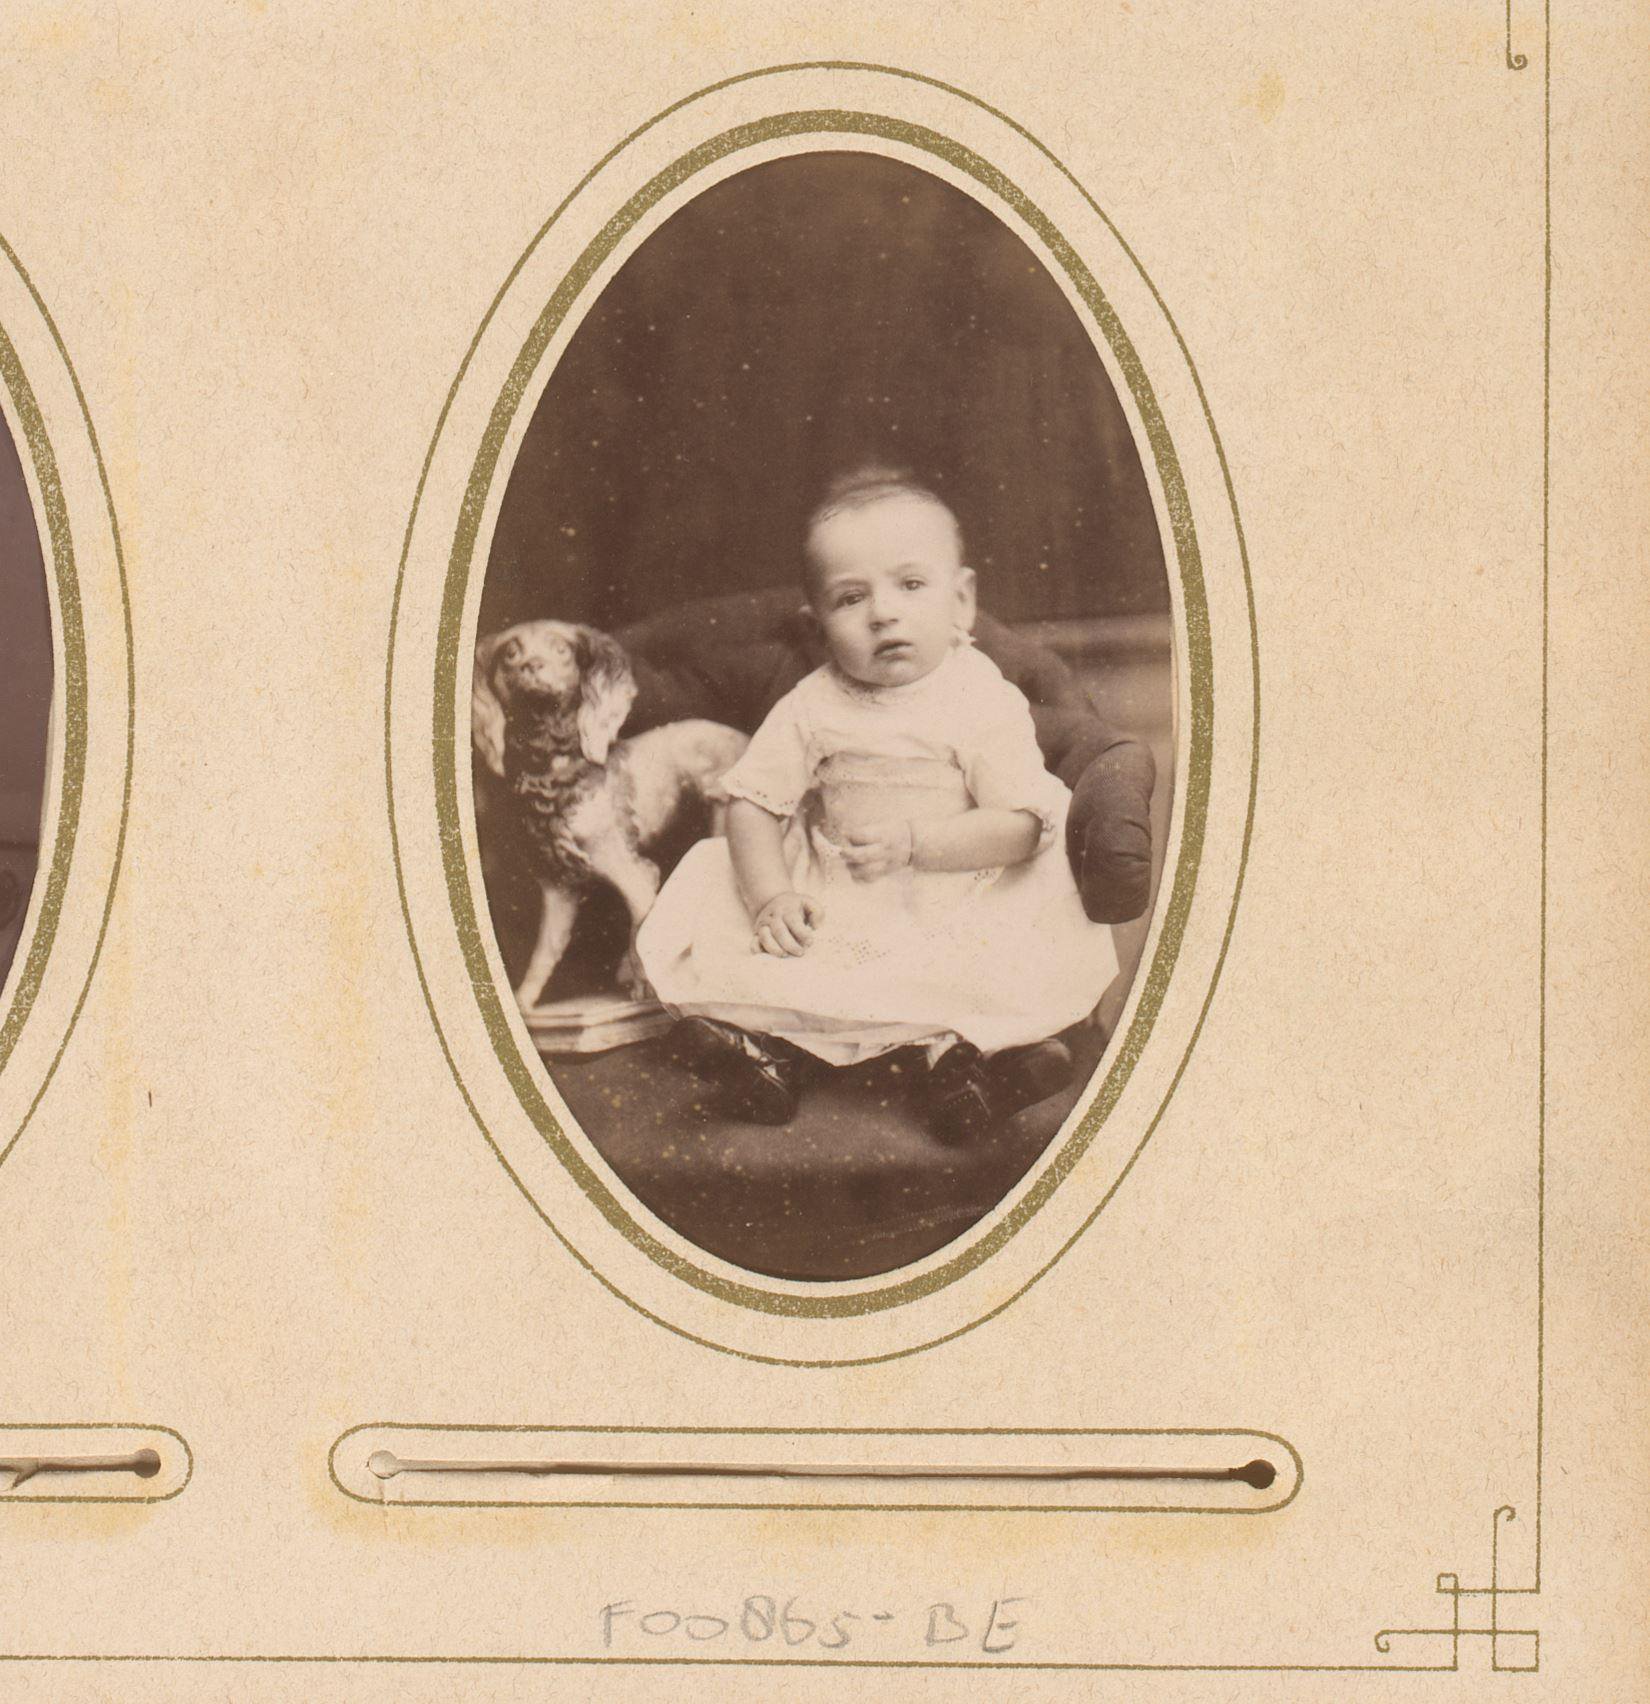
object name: album leaf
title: Portret van een baby, zittend in een stoel met speelgoedhond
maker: hendrik boonstoppel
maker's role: fotograaf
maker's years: 1854-1924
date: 1870-1900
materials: cardboard, photographic support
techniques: albumen print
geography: dordrecht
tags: sitting figure, (playing with) toy animals, historical persons, infant, baby ~ the ages of man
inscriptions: inscription: ‘Photographie/ H. Boonstoppel/ DORDRECHT/ over het Postkantoor./ Portretten kunnen op iedere groote nabesteld worden.’